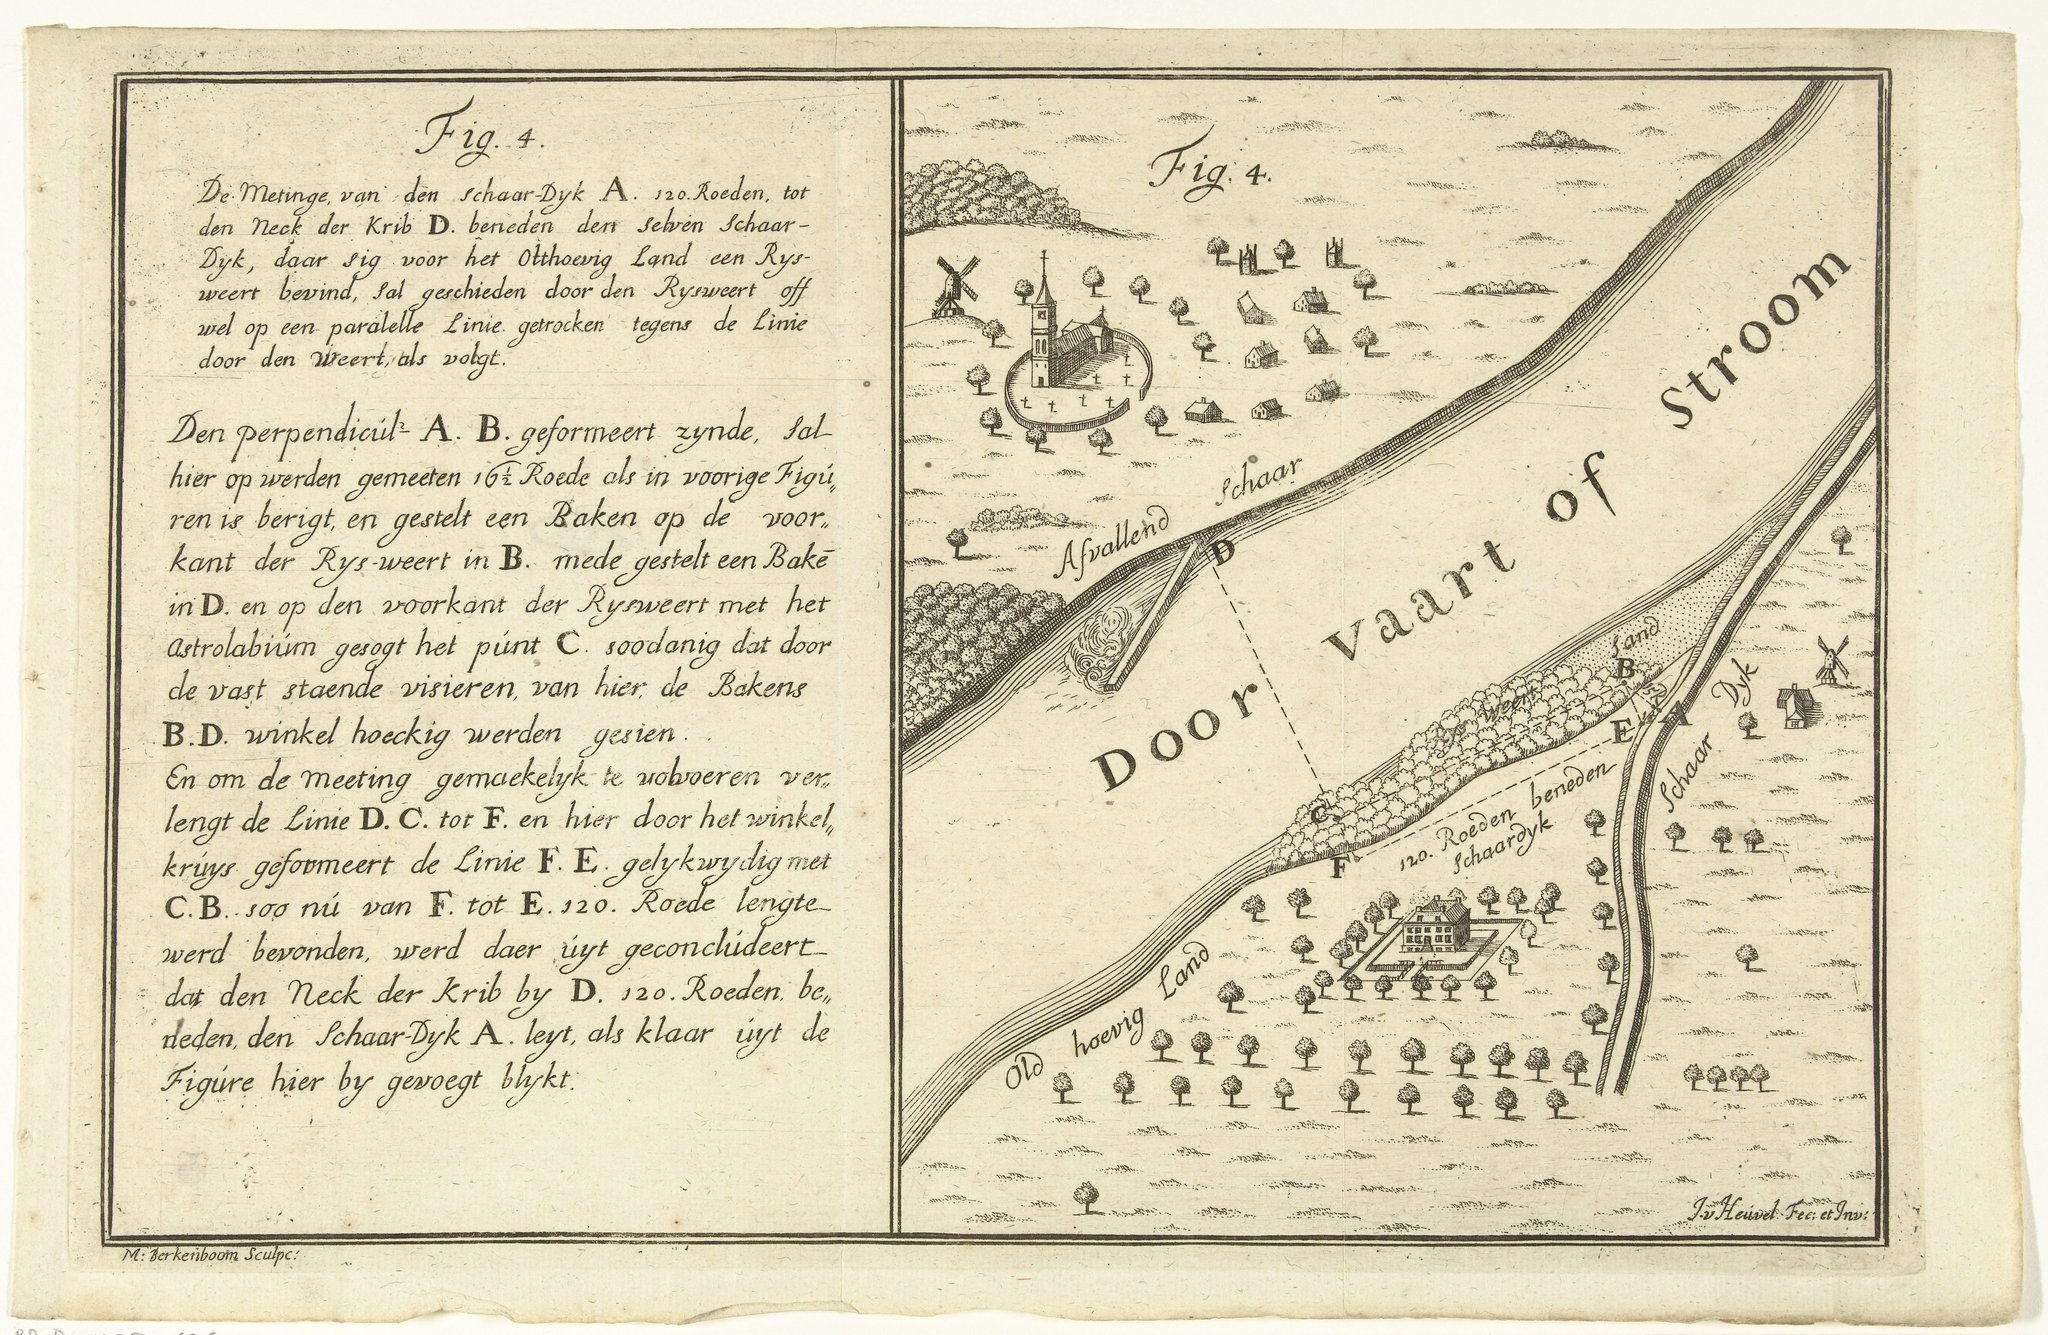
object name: print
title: Fig. 4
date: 1650-1715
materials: paper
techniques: etching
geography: nijmegen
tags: swamps and polders, dikes, levee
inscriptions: collector's mark: Lugt 2228, collector's mark: Lugt 2760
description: Plattegrond van een stuk rivier met een schaardijk bij een landhuis. Links een legenda van A-F. Prent maakt deel uit van een serie prenten over waterbouwkunde en inpoldering.